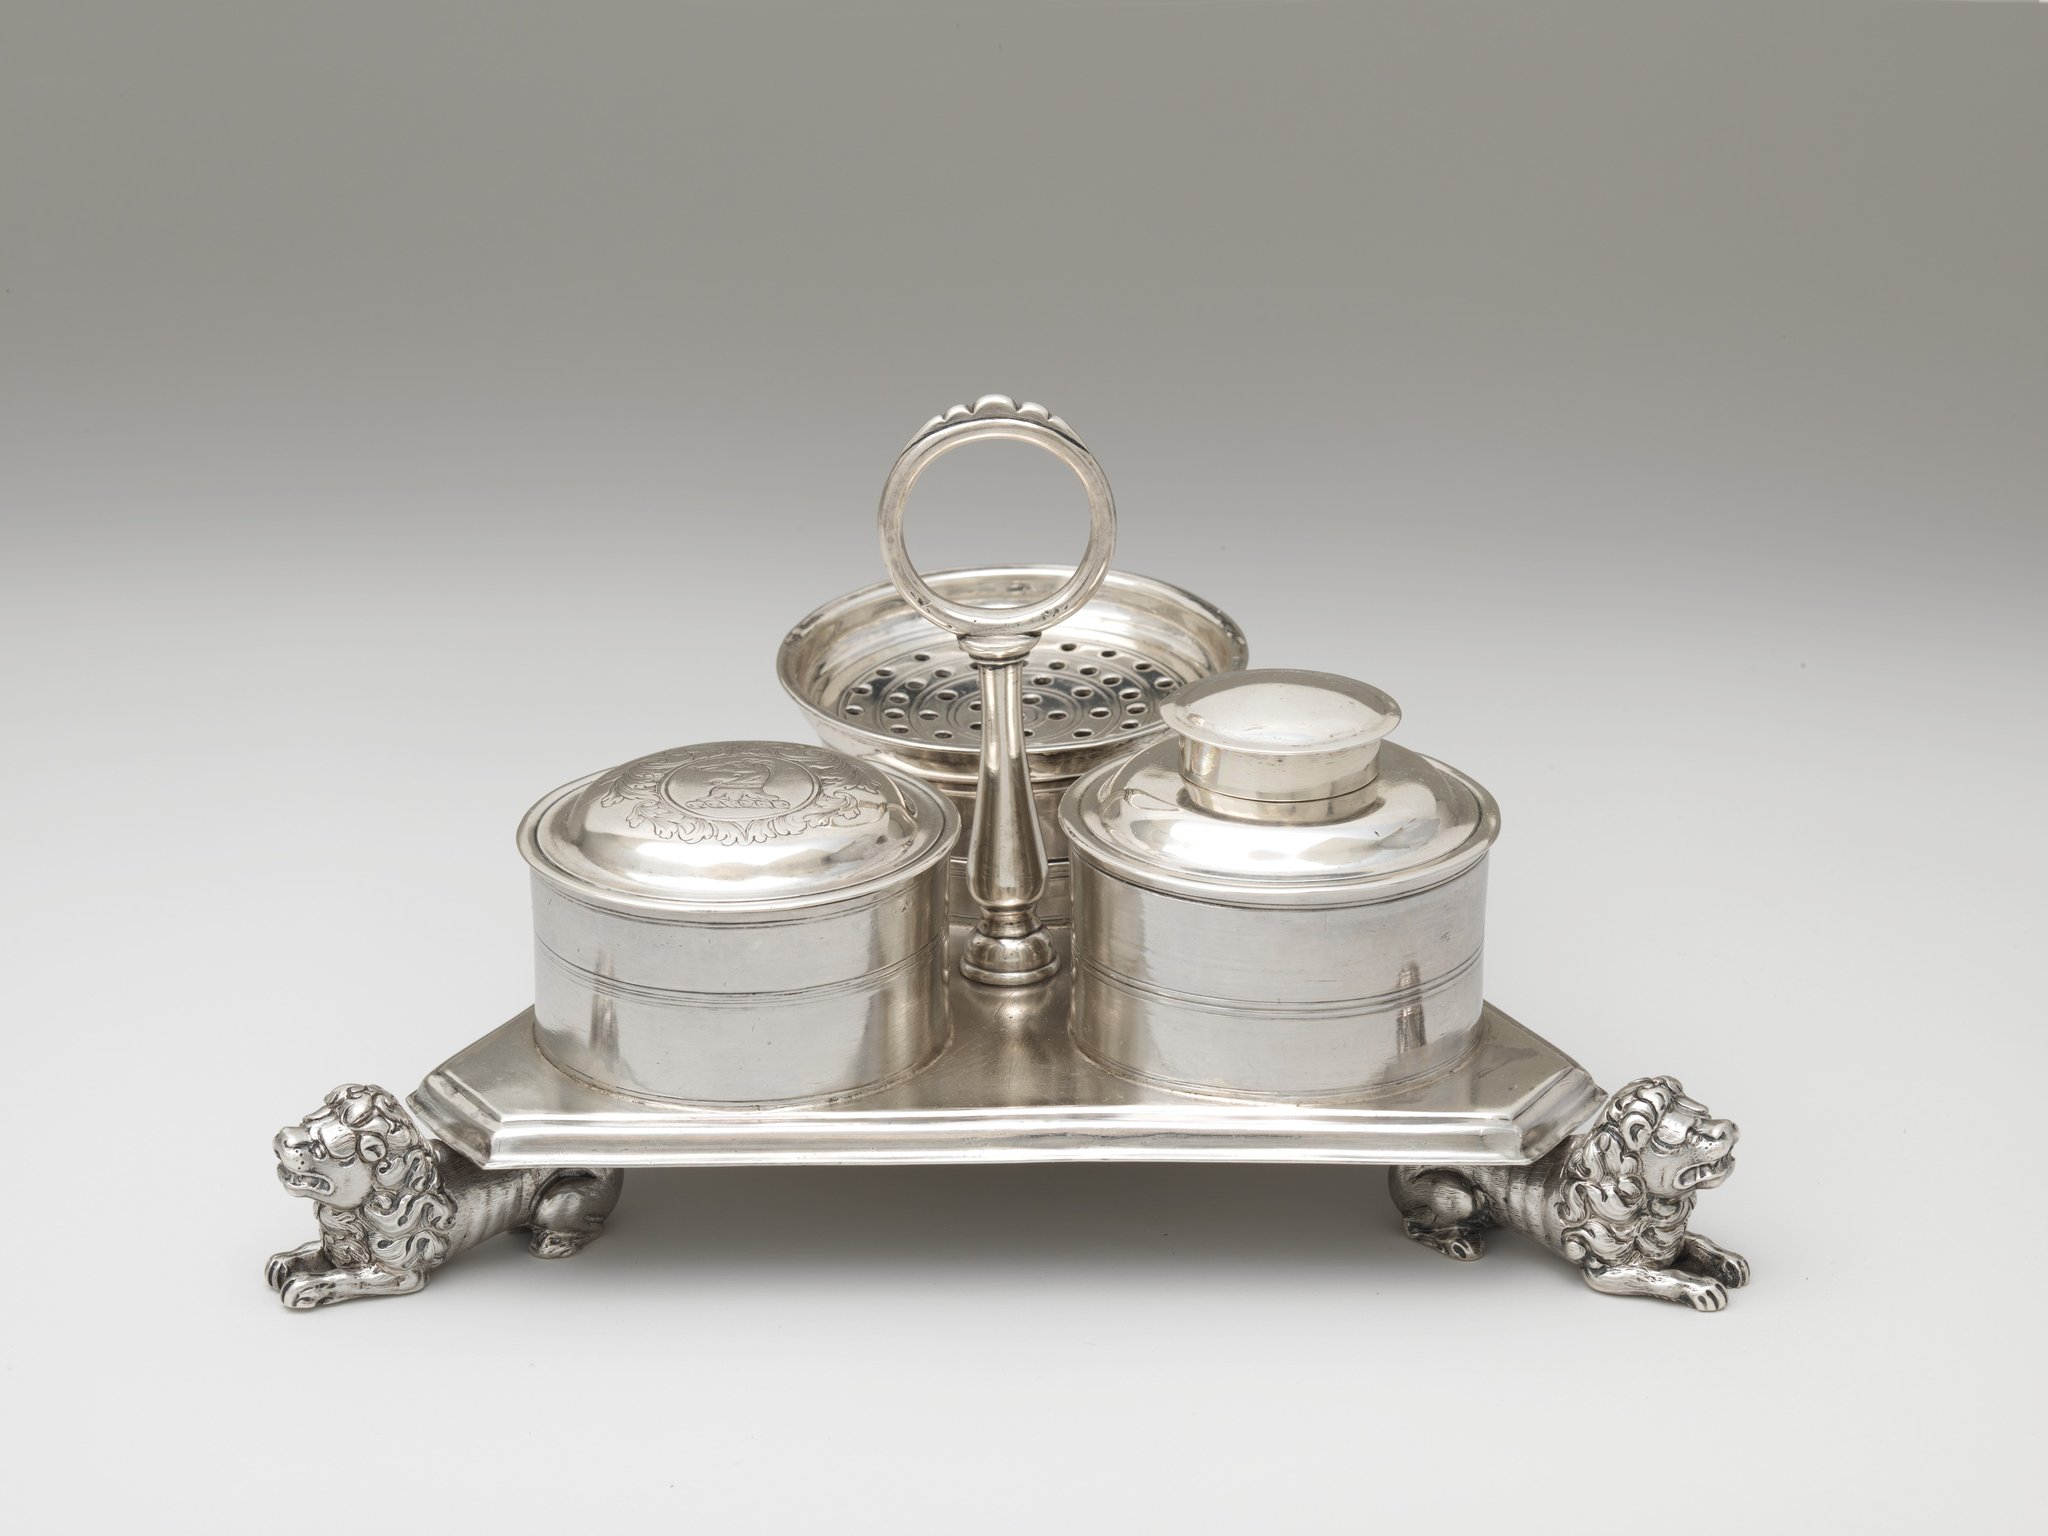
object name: inkstand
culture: american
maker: john coney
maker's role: maker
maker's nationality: american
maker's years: 1655-1722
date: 1710-1720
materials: silver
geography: united states